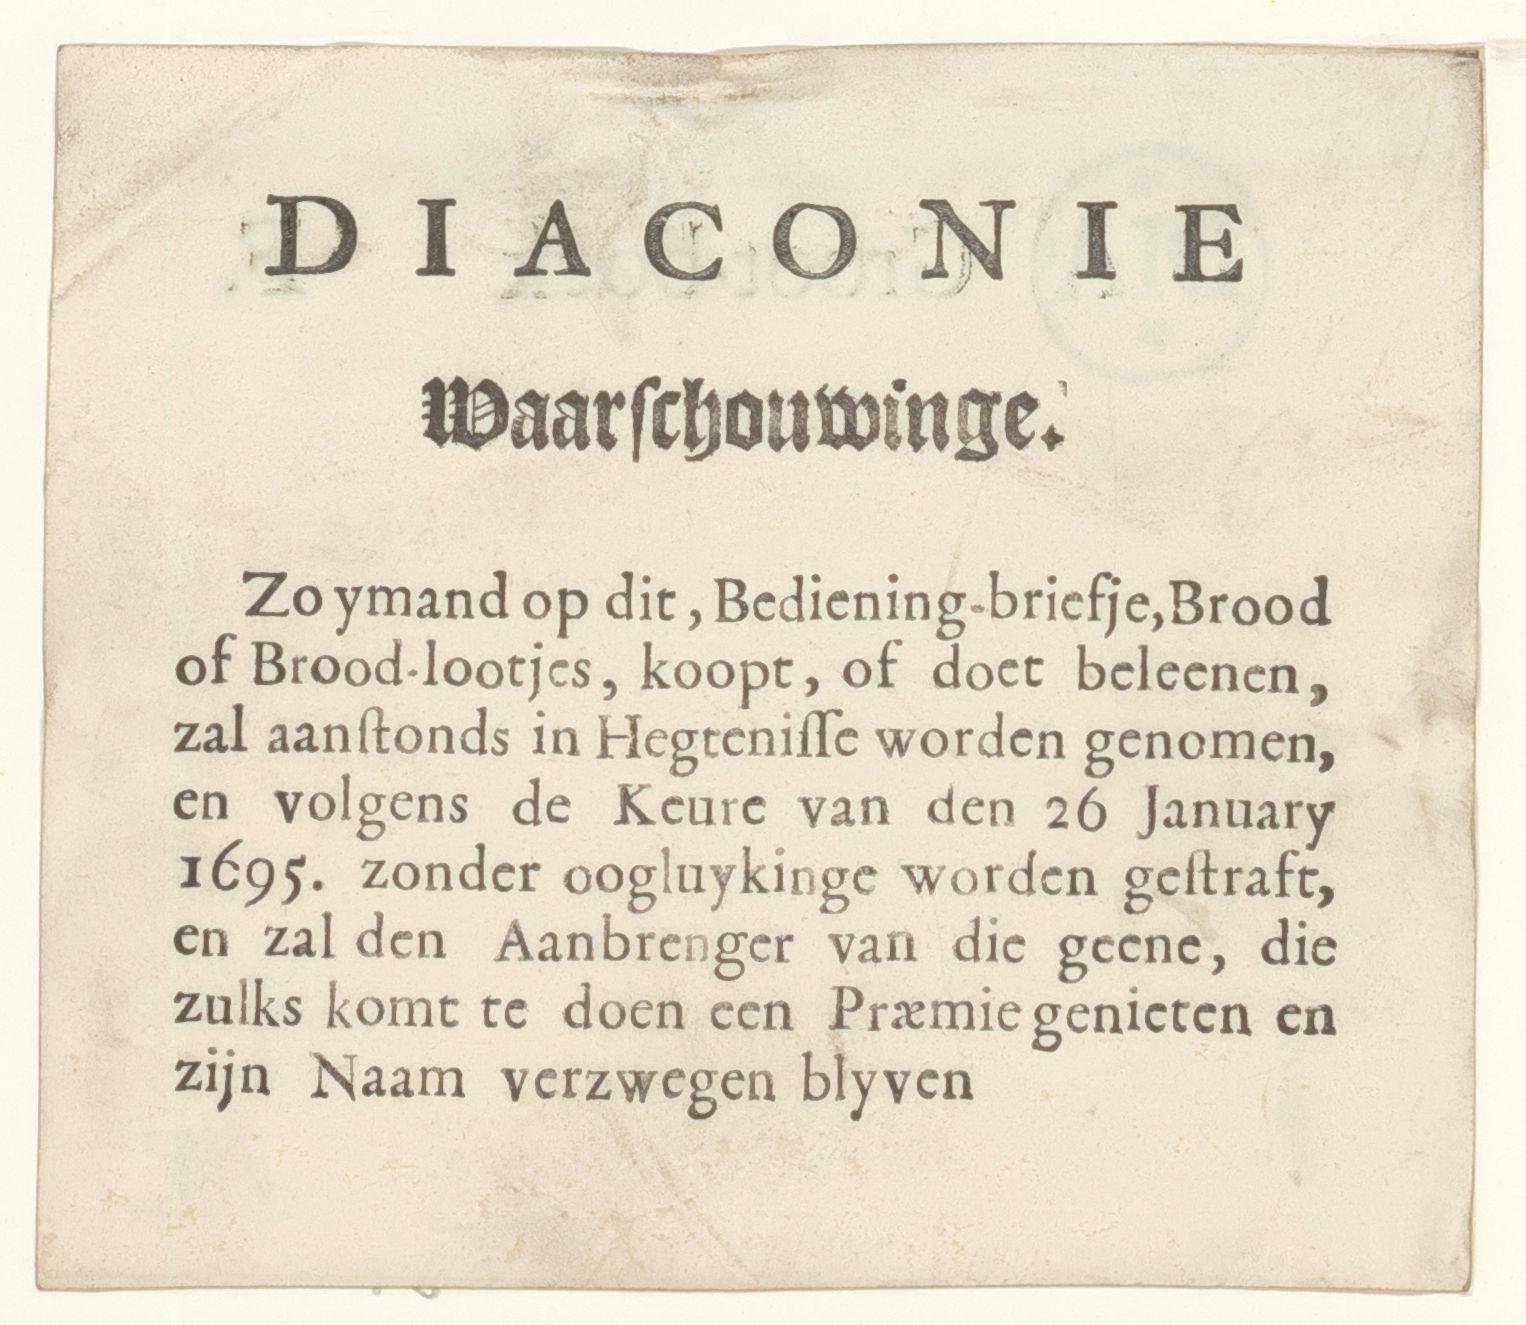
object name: text sheet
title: Waarschuwing van de Diaconie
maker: Anonymous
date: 1695-1799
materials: paper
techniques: letterpress printing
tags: giving alms or other charity, e.g.: handing out food, theft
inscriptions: collector's mark: Lugt 1641, stamp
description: Waarschuwing van de Diaconie tegen misbruik van de Bedieningsbrief. Onderwerpsrubrieken binnen de Atlas Zeden en Gewoonten: Godsdienst, Ned. Hervormden, (Oudtijds Gereformeerden).